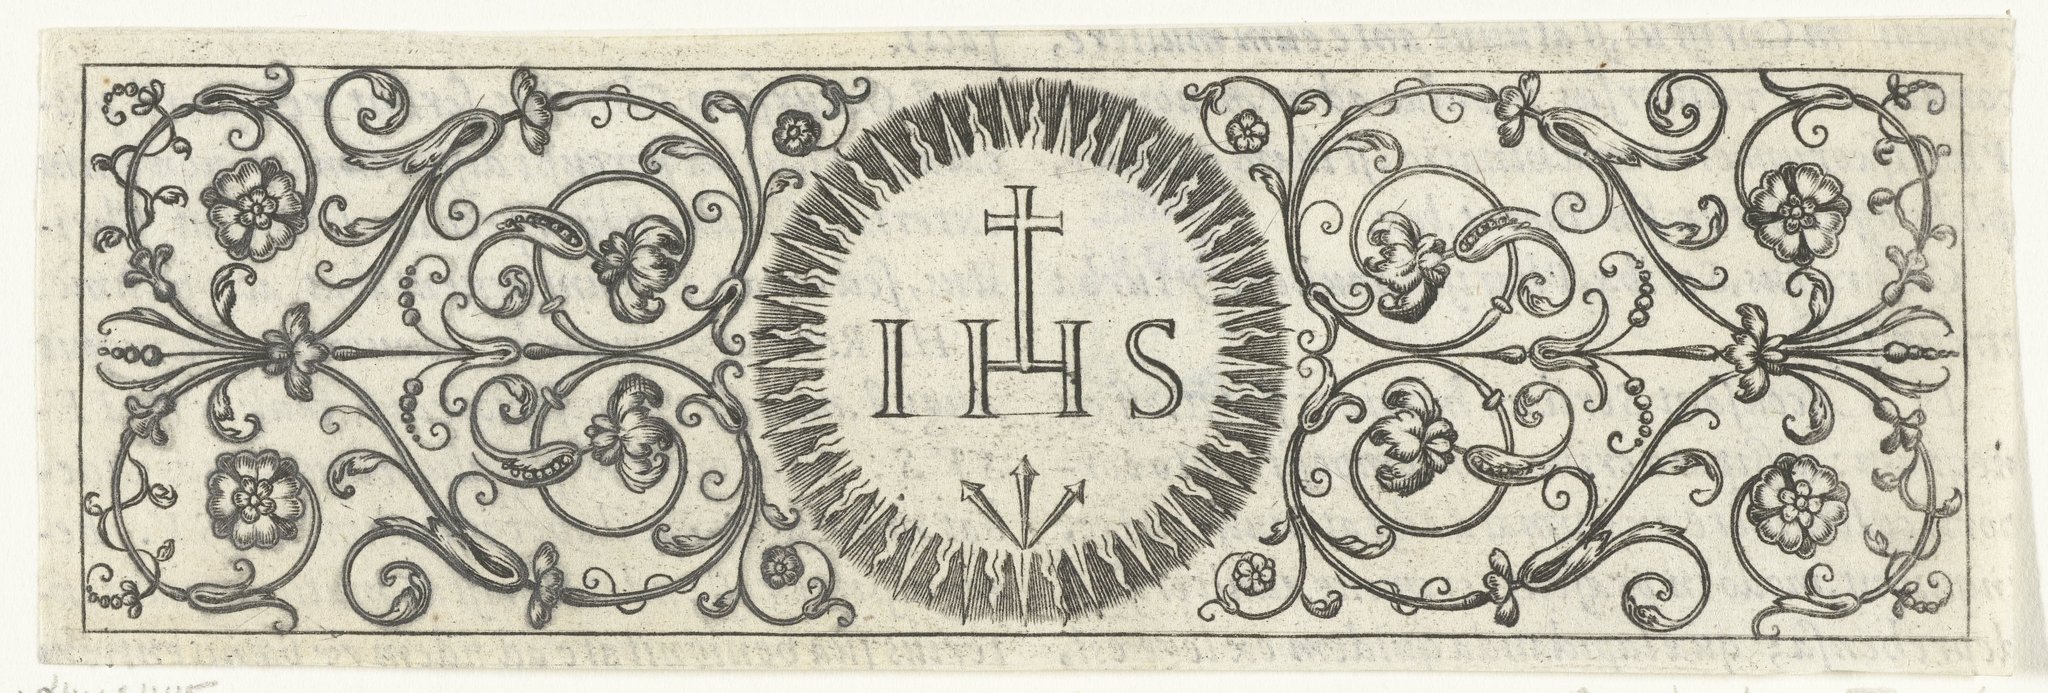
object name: ornament print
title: Adnotationes et meditationes…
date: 1594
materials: paper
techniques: engraving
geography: netherlands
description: Afkomstig uit serie van 5 bladen uit het boek Adnotationes et meditationes… van P. Jeronimo Nadal.